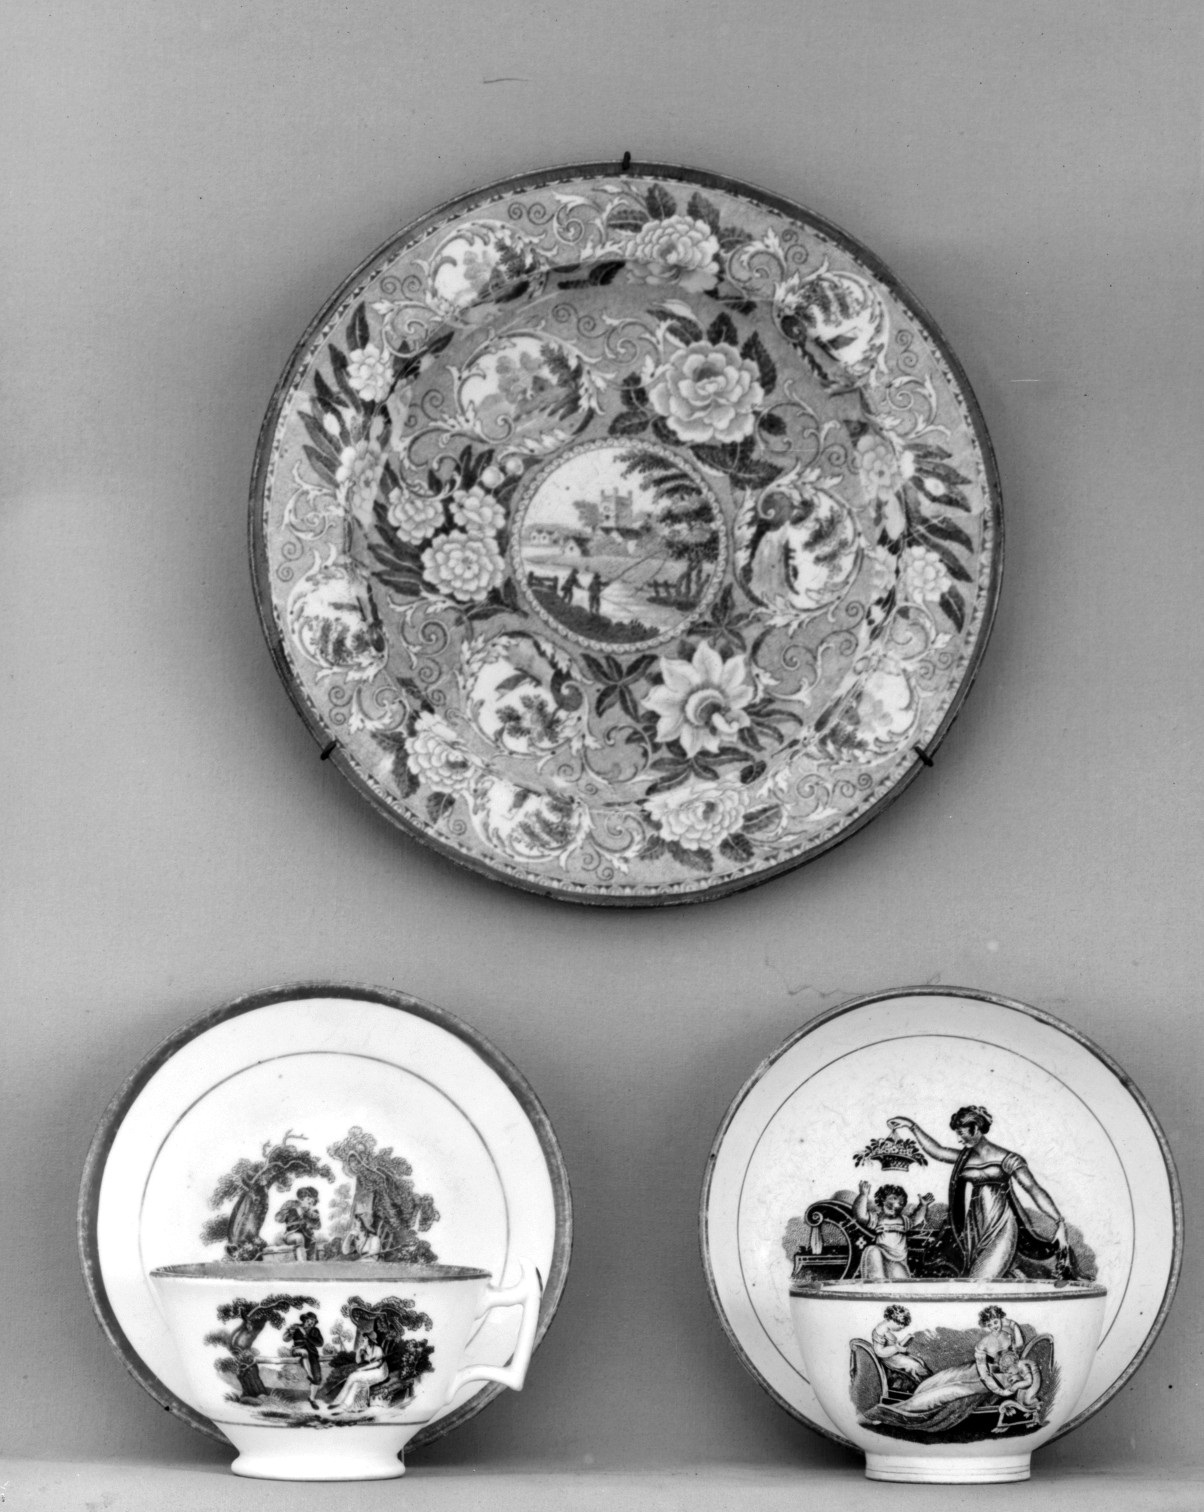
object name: plate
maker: james and ralph clews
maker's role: factory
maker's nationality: british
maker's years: 1813-1836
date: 1801-1900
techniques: printing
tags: women,fishing,flowers